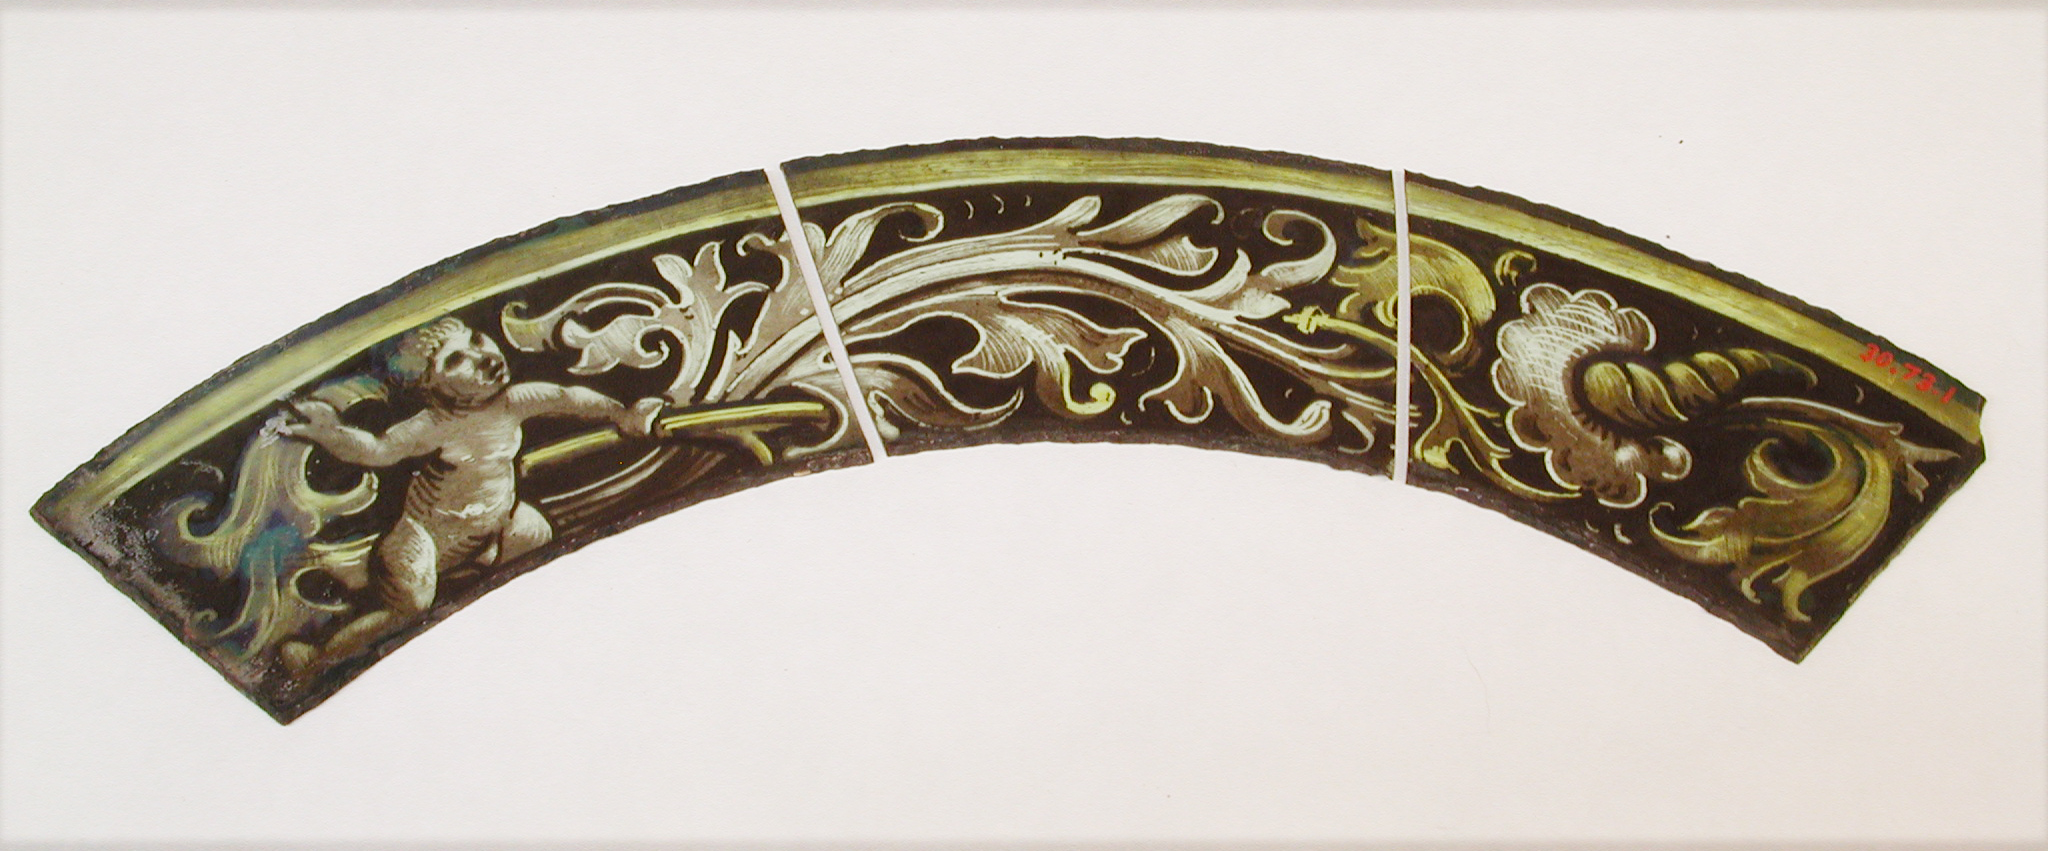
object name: border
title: Border fragment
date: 1501-1600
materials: glass, paint, pigment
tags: children